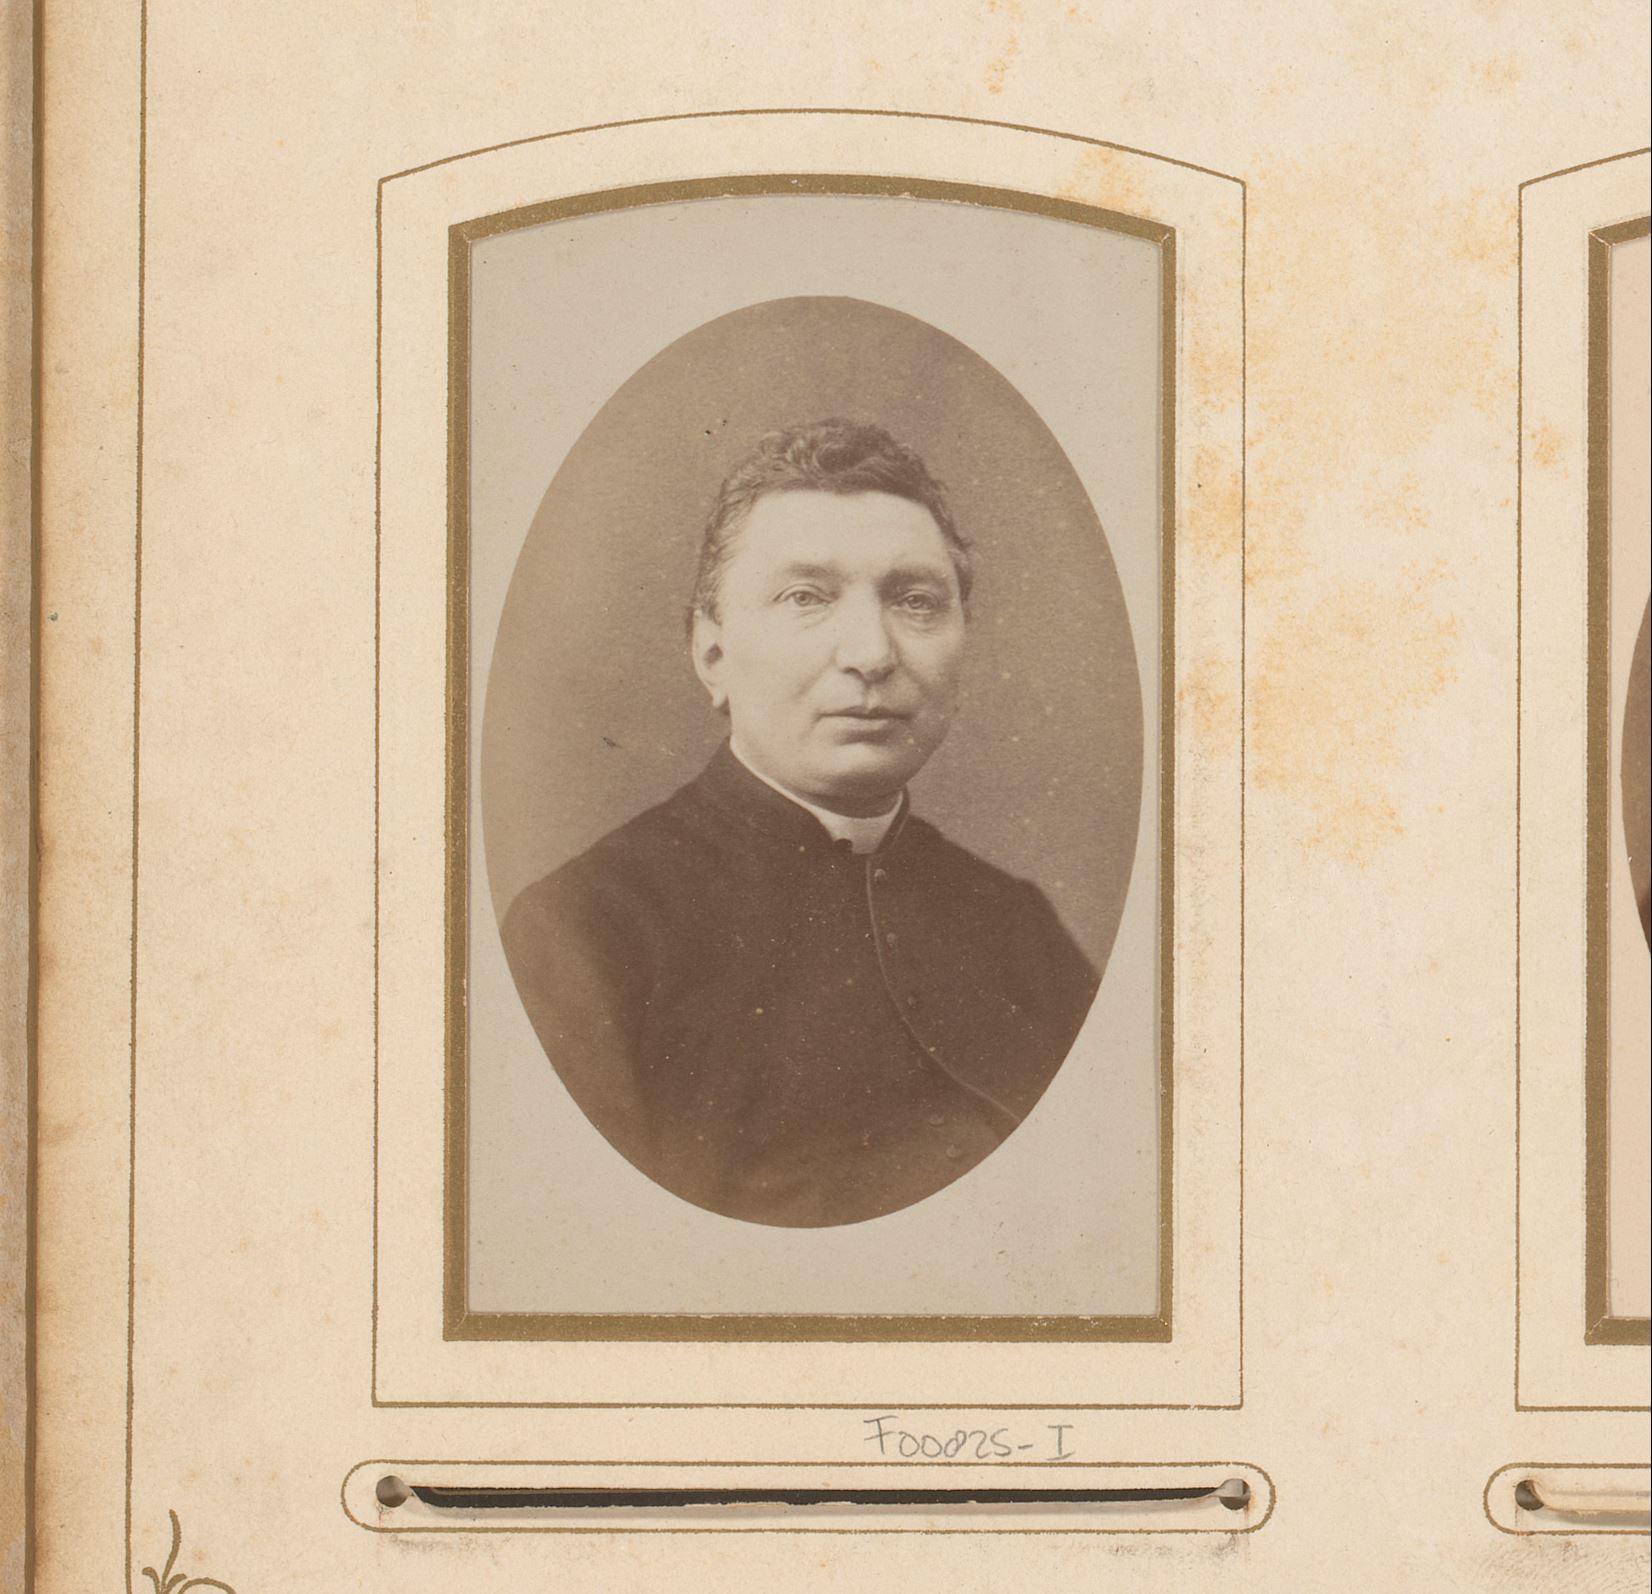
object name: photograph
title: Portret van een geestelijke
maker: pieter wilhelmus roemer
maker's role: fotograaf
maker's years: 1838-1924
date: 1887-1889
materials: cardboard, photographic support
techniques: albumen print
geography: rotterdam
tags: theologian, historical persons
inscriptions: inscription: ‘Photographie/ Artistique/ P.W. Roemer/ Rotterdam/ Stationsweg 34.’